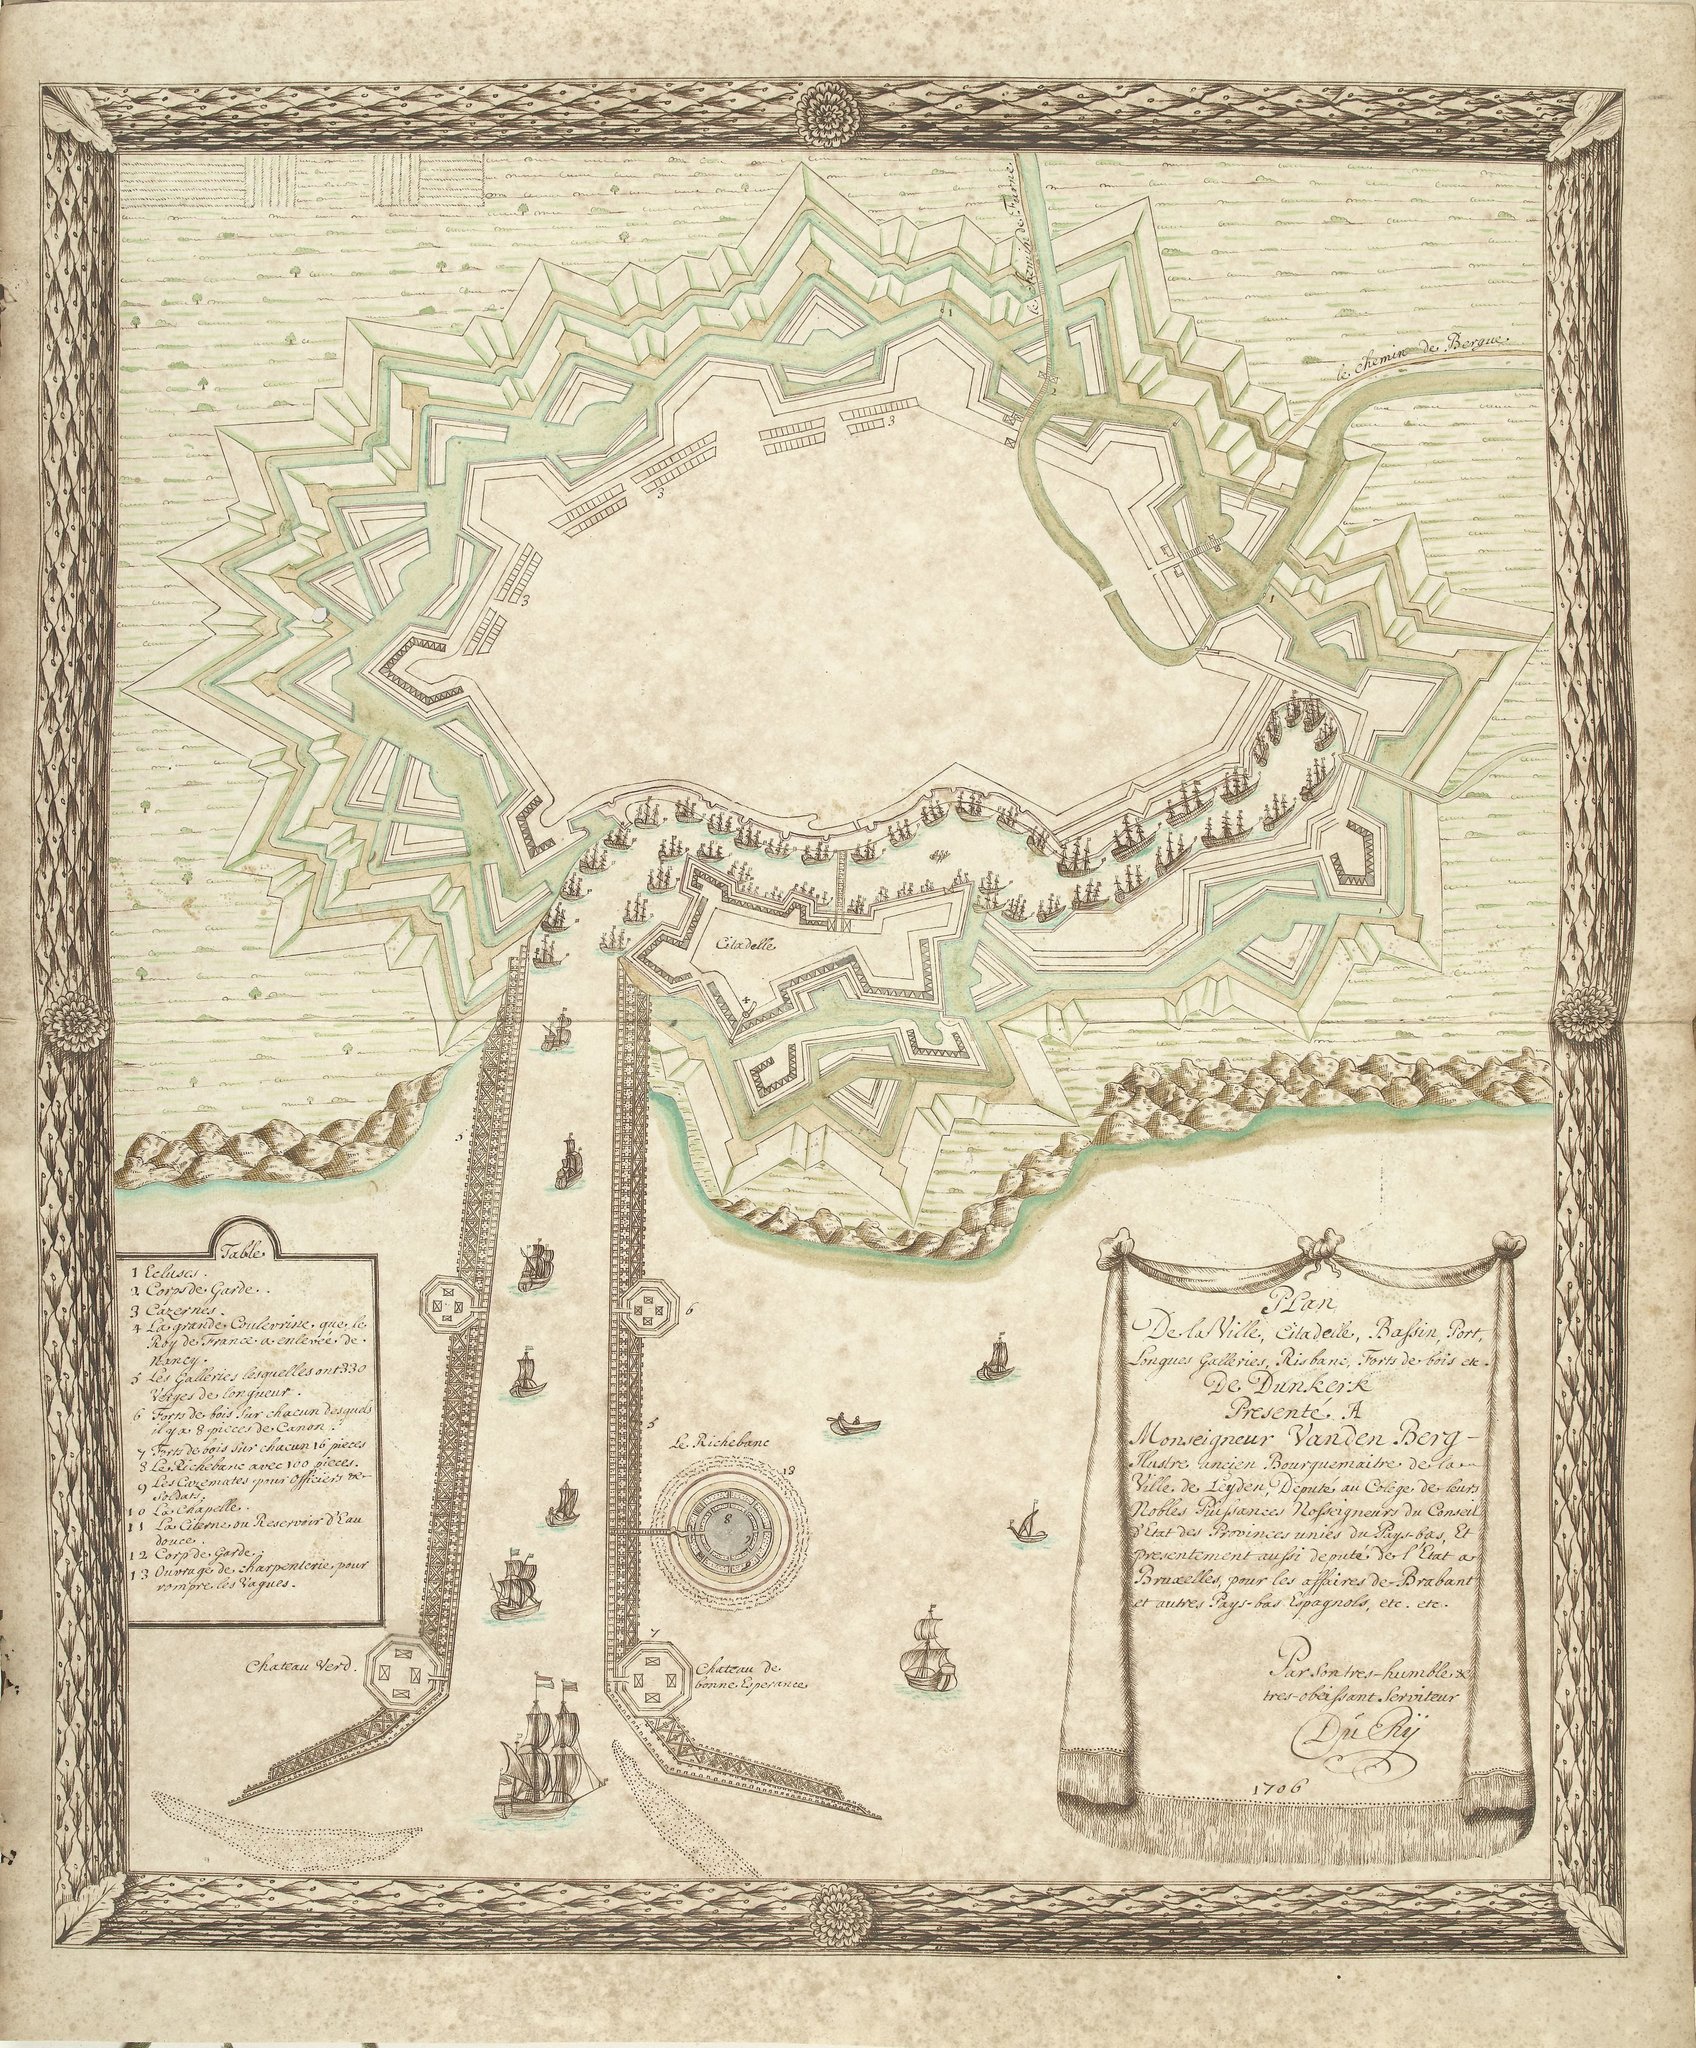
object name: map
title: Plattegrond van Duinkerke, 1706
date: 1706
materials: paper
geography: netherlands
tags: fortress, maps of cities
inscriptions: date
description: Plattegrond van de versterkingen om de stad Duinkerke, 1706. Rechtsonder een cartouche met de titel en opdracht, links een cartouche met de legenda 1-13 in het Frans. Onderdeel van een verzameling getekende plannen van versterkte plaatsen in Nederland en omringende landen ten tijde van de Spaanse Successieoorlog (deel C).